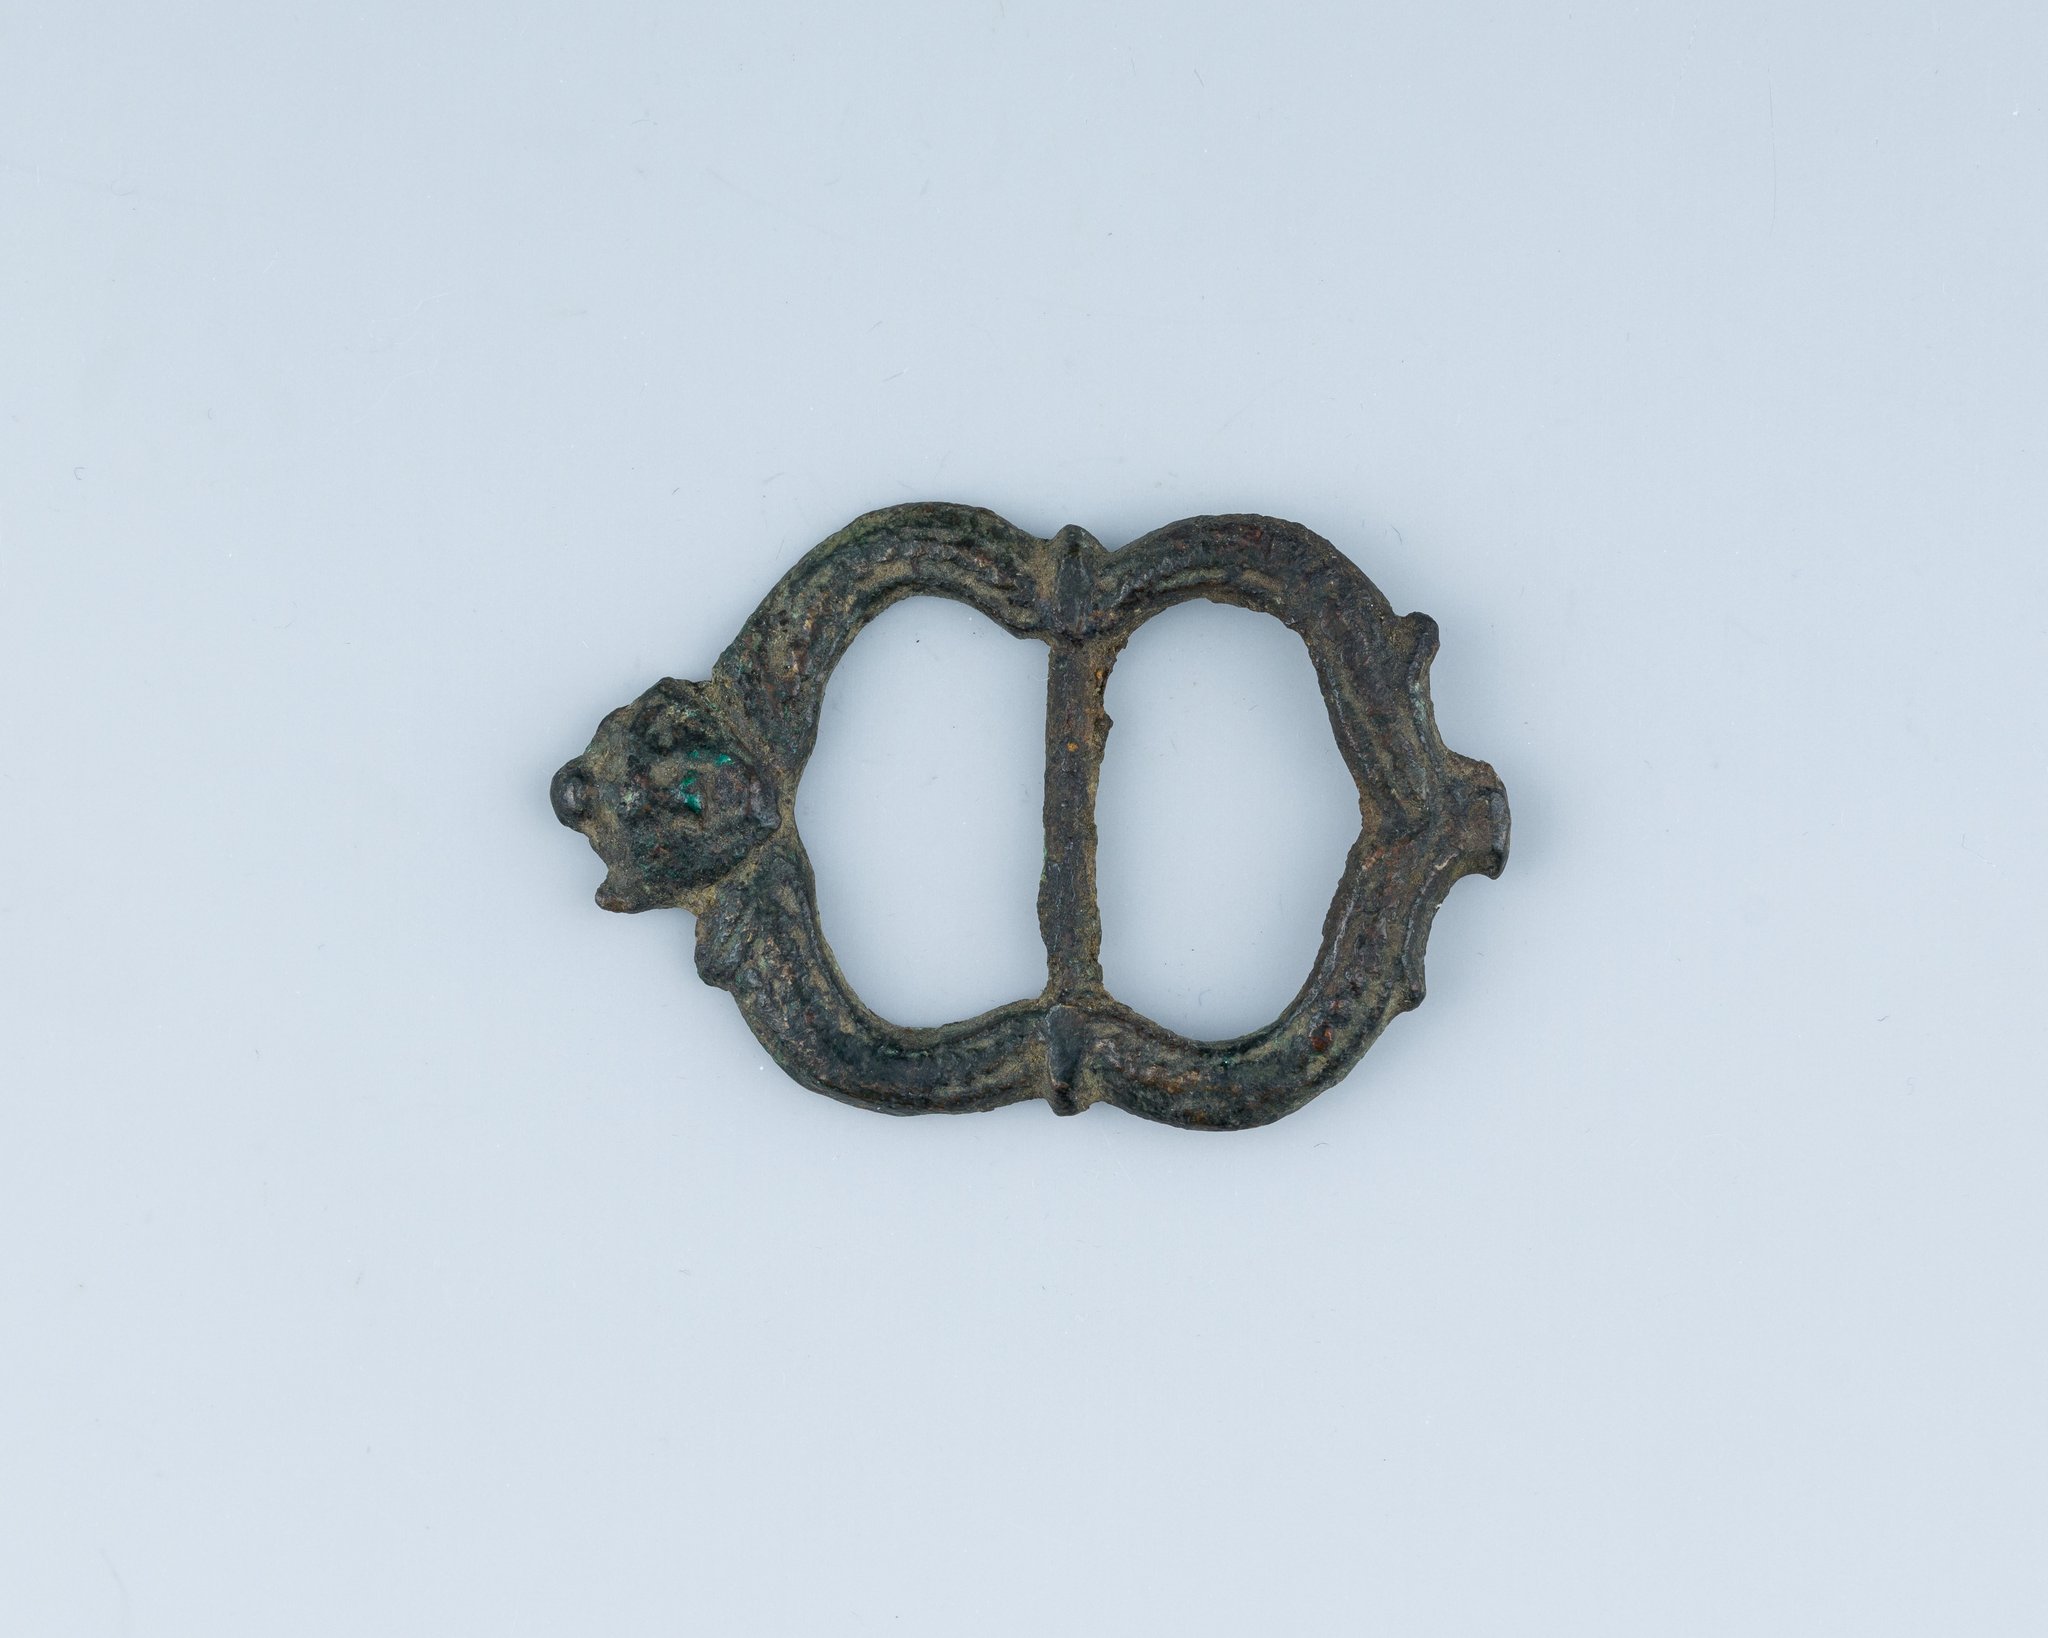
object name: buckle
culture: german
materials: bronze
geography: germany